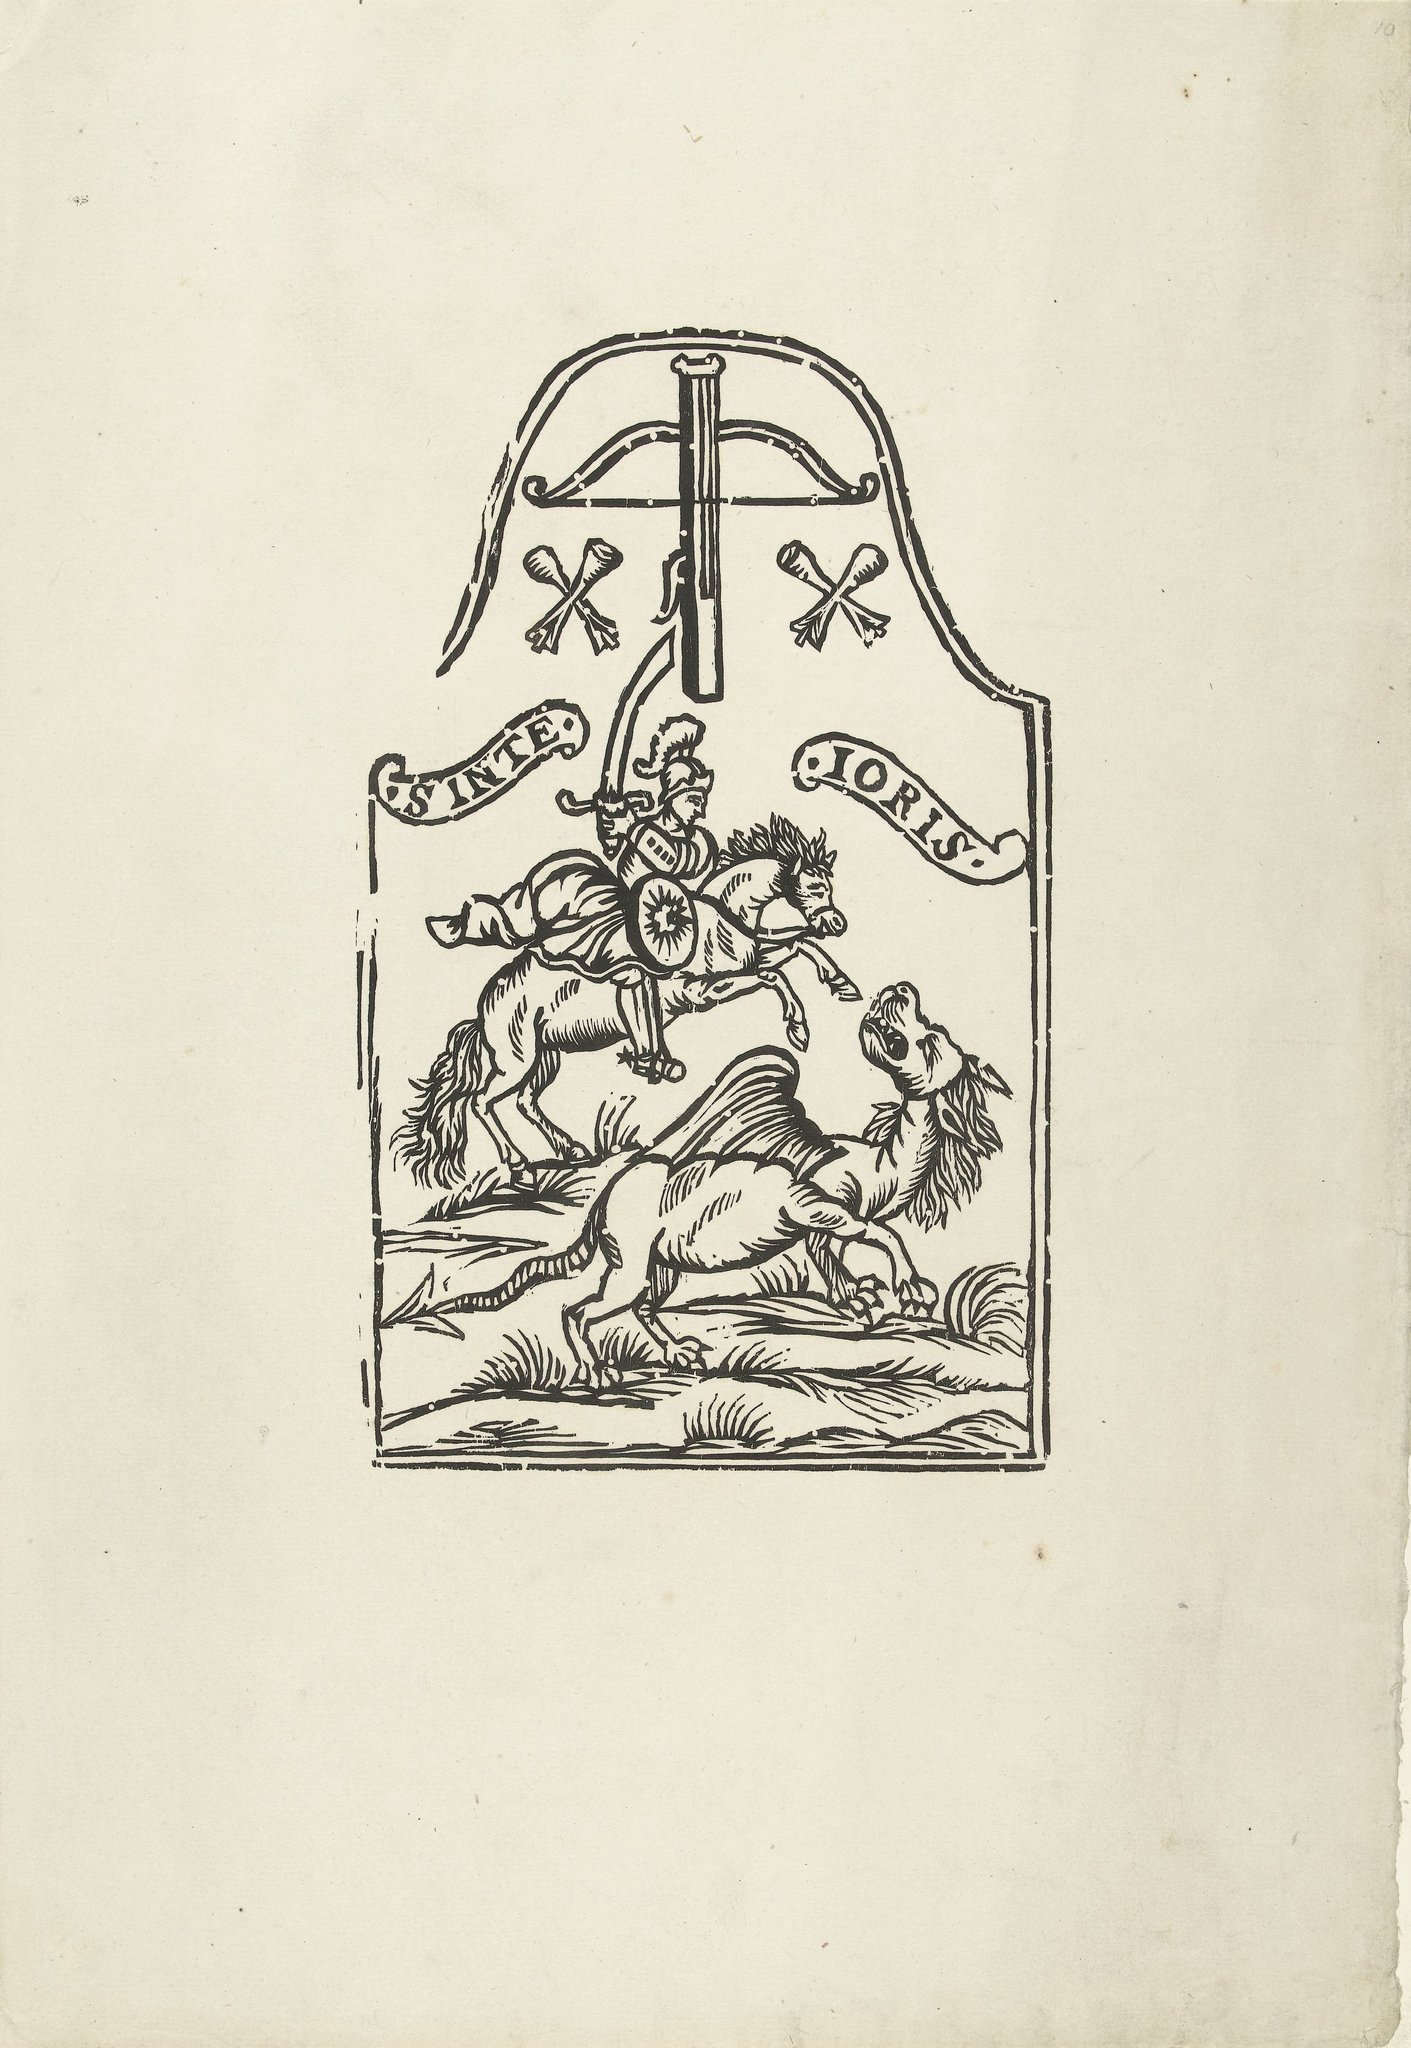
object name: print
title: Sinte Ioris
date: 1700-1725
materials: paper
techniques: woodcut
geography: southern netherlands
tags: the warrior martyr george (georgius); possible attributes: banner (red cross on white field), (red) cross, dragon, (white) horse, broken lance, shield (with cross), sword - miraculous activities and events ~ male saint, archer's weapons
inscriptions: collector's mark: Lugt 2760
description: Paneel met Sint Joris die de draak verslaat, bovenaan een kruisboog met twee paren gekruiste pijlen, Sint-Jorisdoelen.